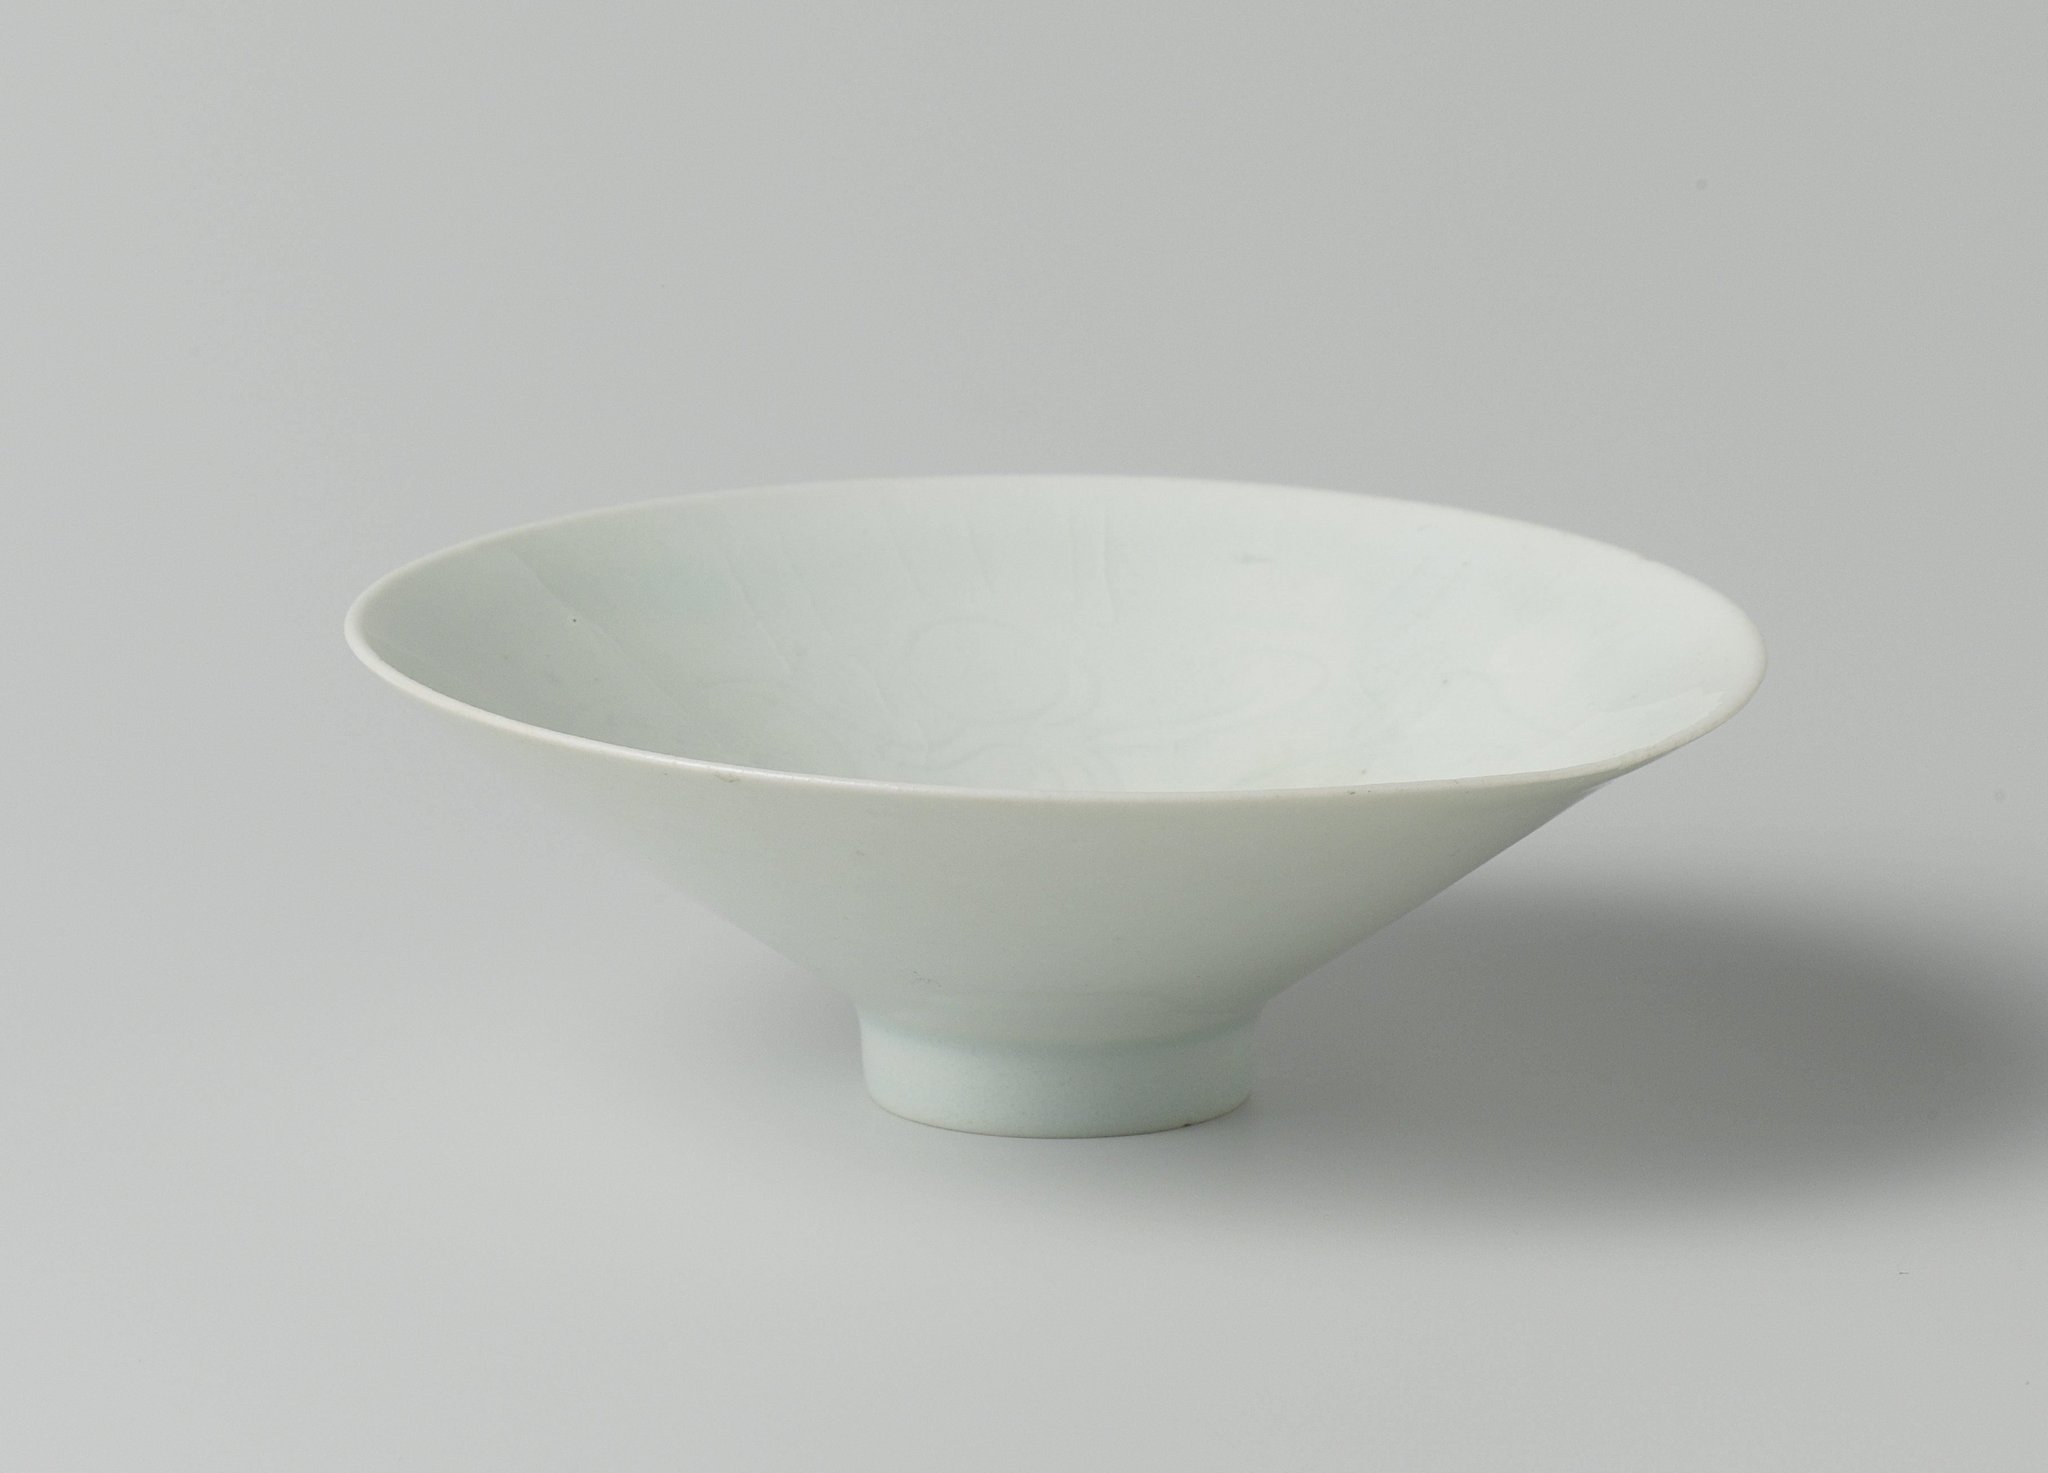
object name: bowl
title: Conical bowl with an incised foliate scrolls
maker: Anonymous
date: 1127-1279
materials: glaze, stoneware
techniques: engraving, firing, turning, vitrification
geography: china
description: Conische kom van steengoed, bedekt met een transparant glazuur met een lichtblauwe tint. De binnenzijde met een ingegrifte decoratie van twee jongens tussen lotusranken[?]. Qingbai.